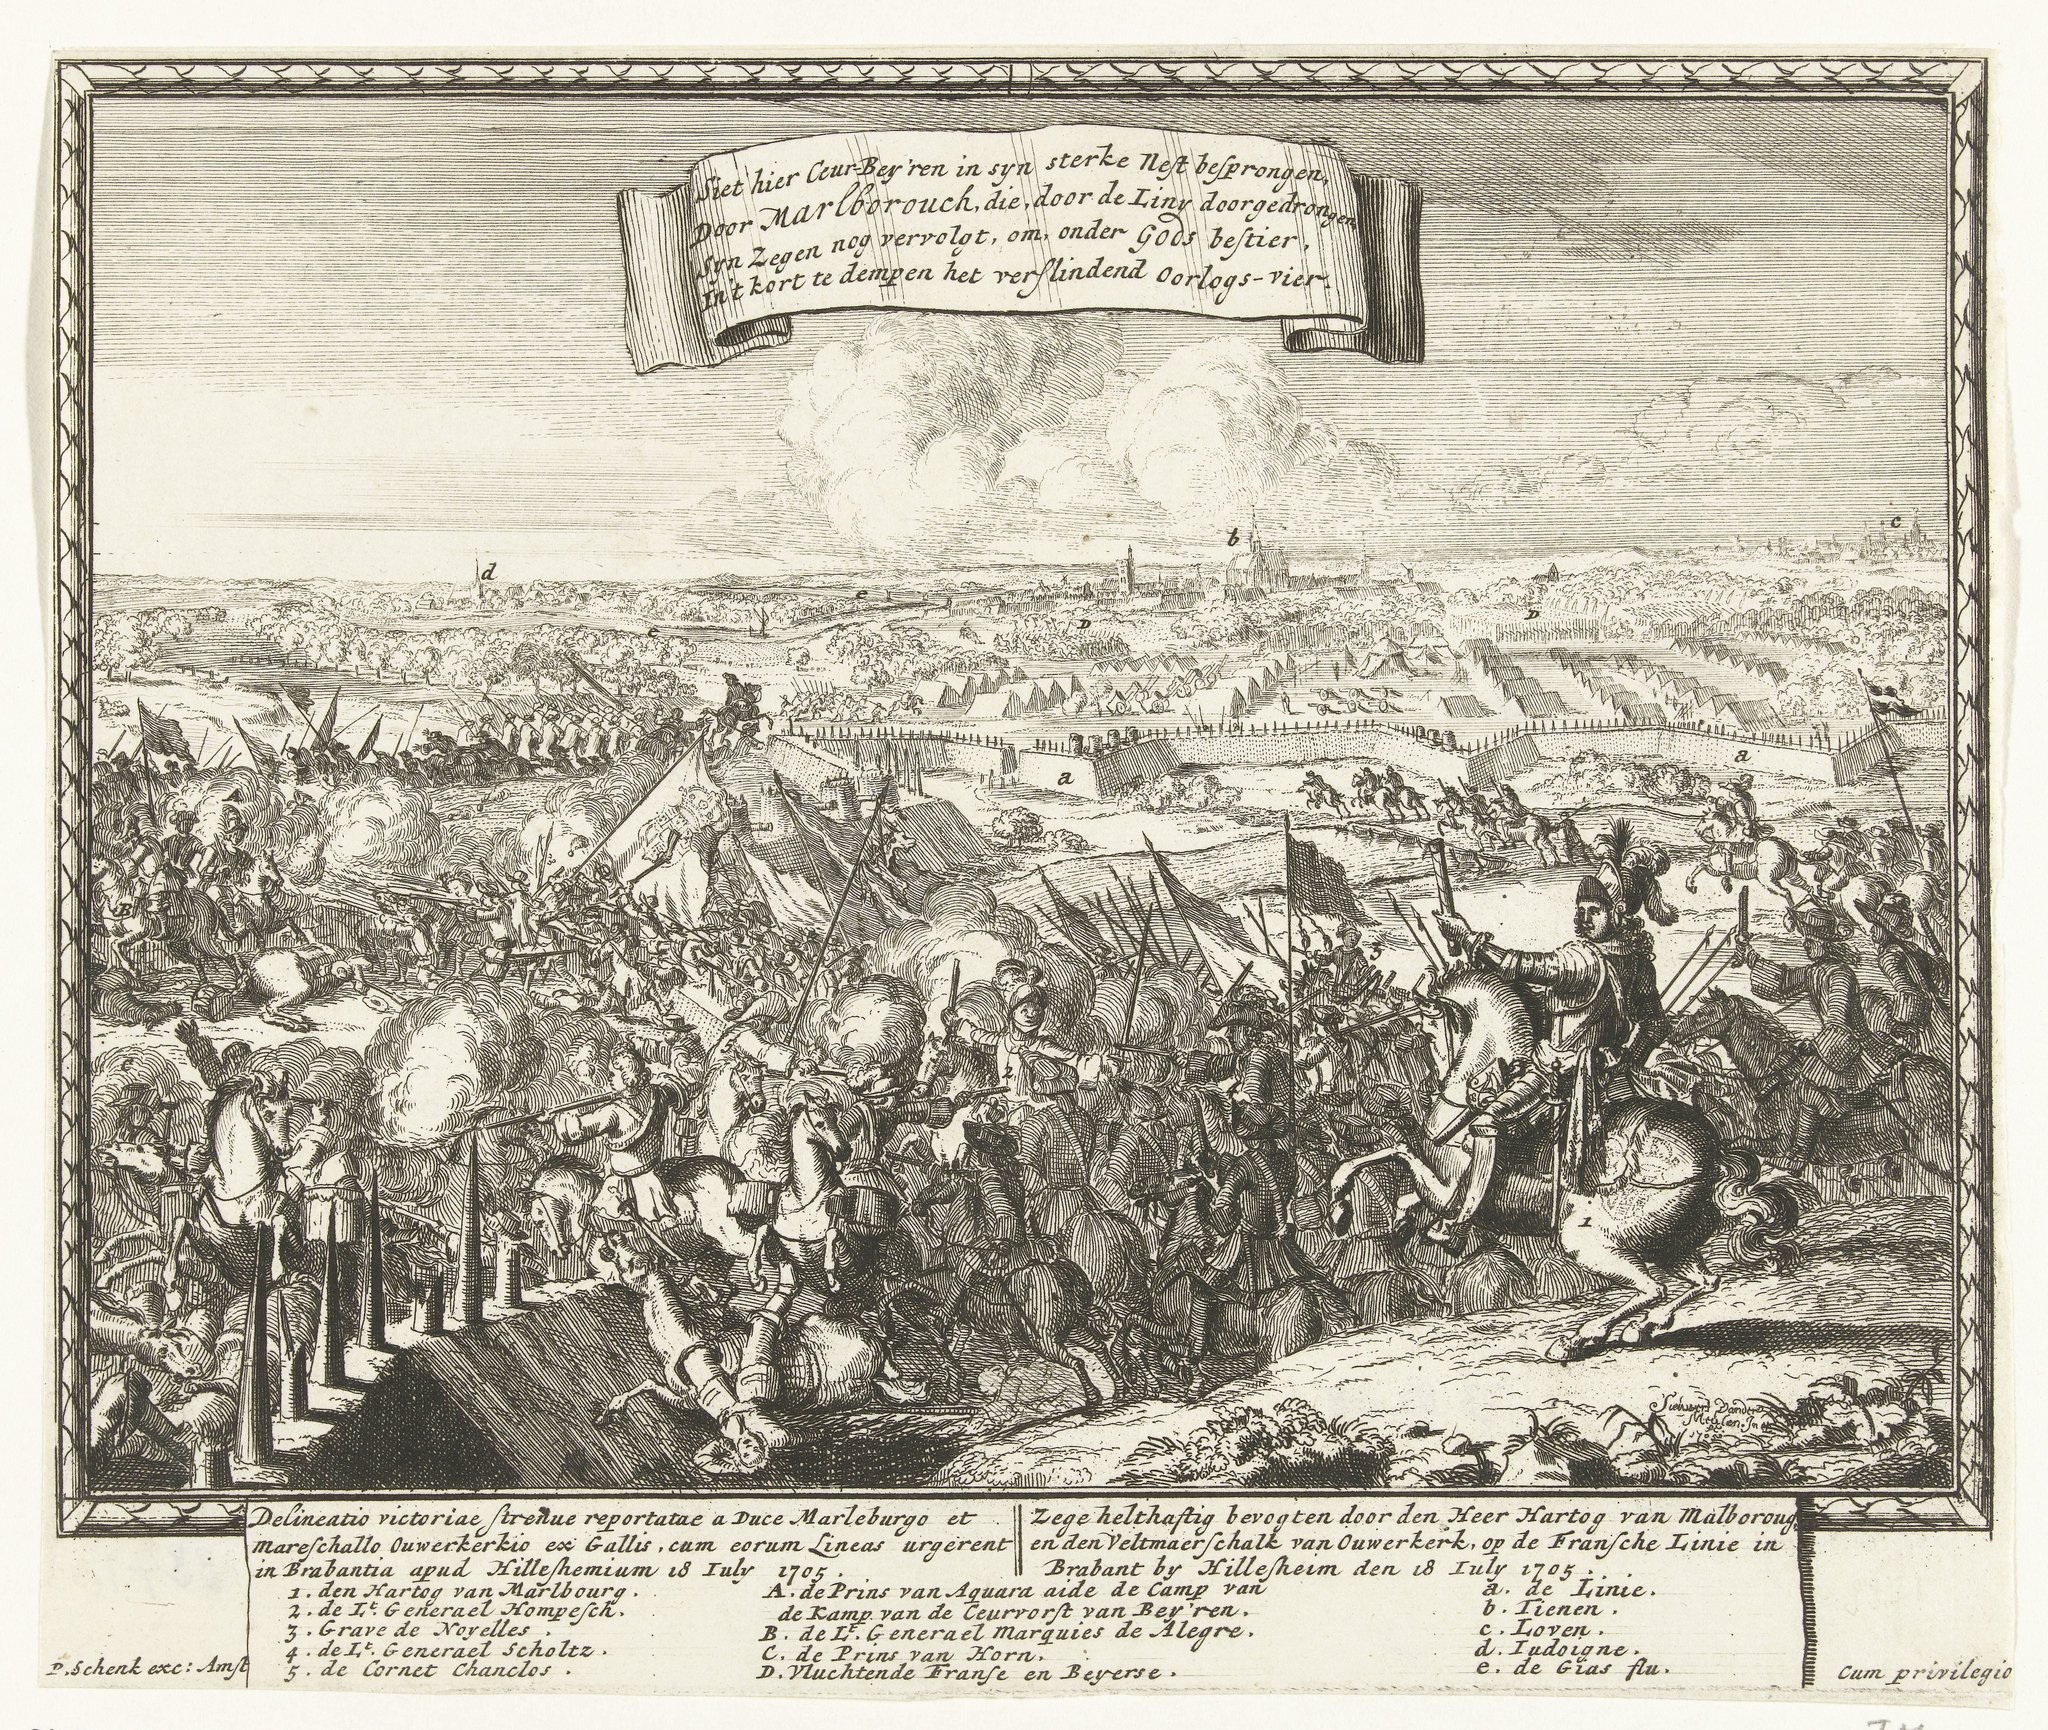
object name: print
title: Doorbreken van de Franse Linies bij Tienen, 1705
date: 1705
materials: paper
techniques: engraving, etching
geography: amsterdam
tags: john churchill (1e hertog van marlborough), battle (+ land forces)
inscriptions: date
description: Het doorbreken door de Geallieerden onder de hertog van Marlborough van de Franse Linies in Brabant met de slag bij Eliksem bij Tienen, 18 juli 1705. In het onderschrift de titels in het Latijn en Nederlands en de legenda's.